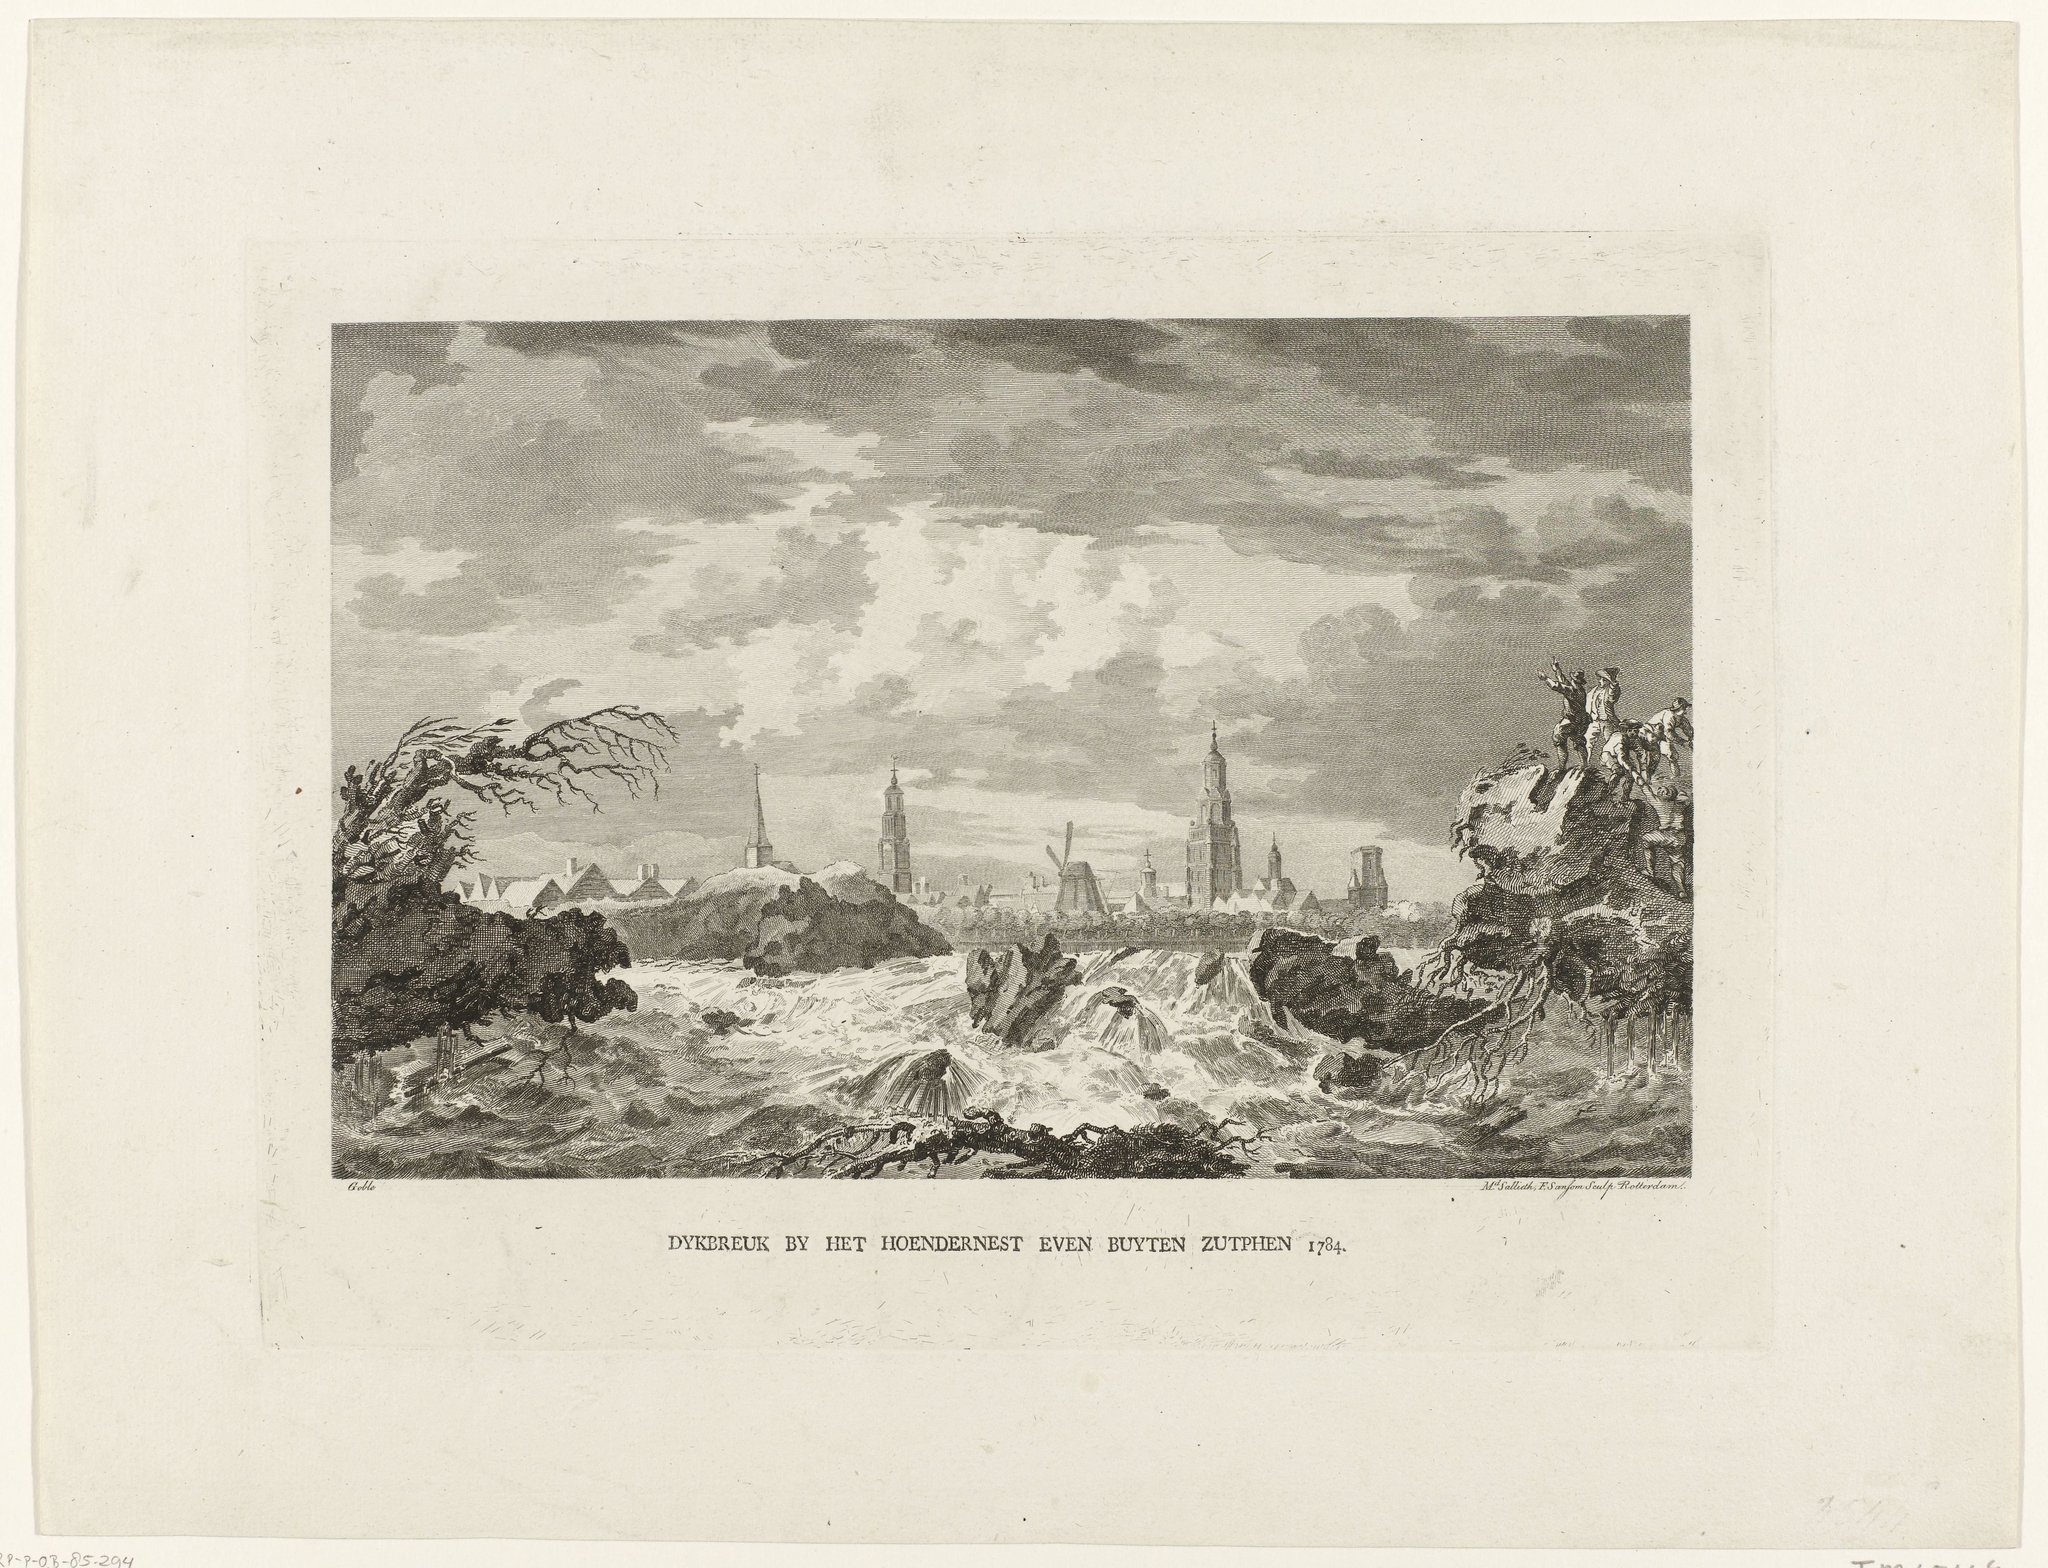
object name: print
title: Dijkdoorbraak buiten Zutphen, 1784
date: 1784-1785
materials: paper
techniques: engraving, etching, letterpress printing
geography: rotterdam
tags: dike-break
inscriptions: collector's mark: Lugt 2228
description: Gebruikt als illustratie in: Naauwkeurige beschryving der overstroomingen, benevens derzelver treurige gevolgen (...) in den jaare MDCCLXXXIV voorgevallen. Leiden: F. de Does, Amsterdam: I. de Jongh, 1785.